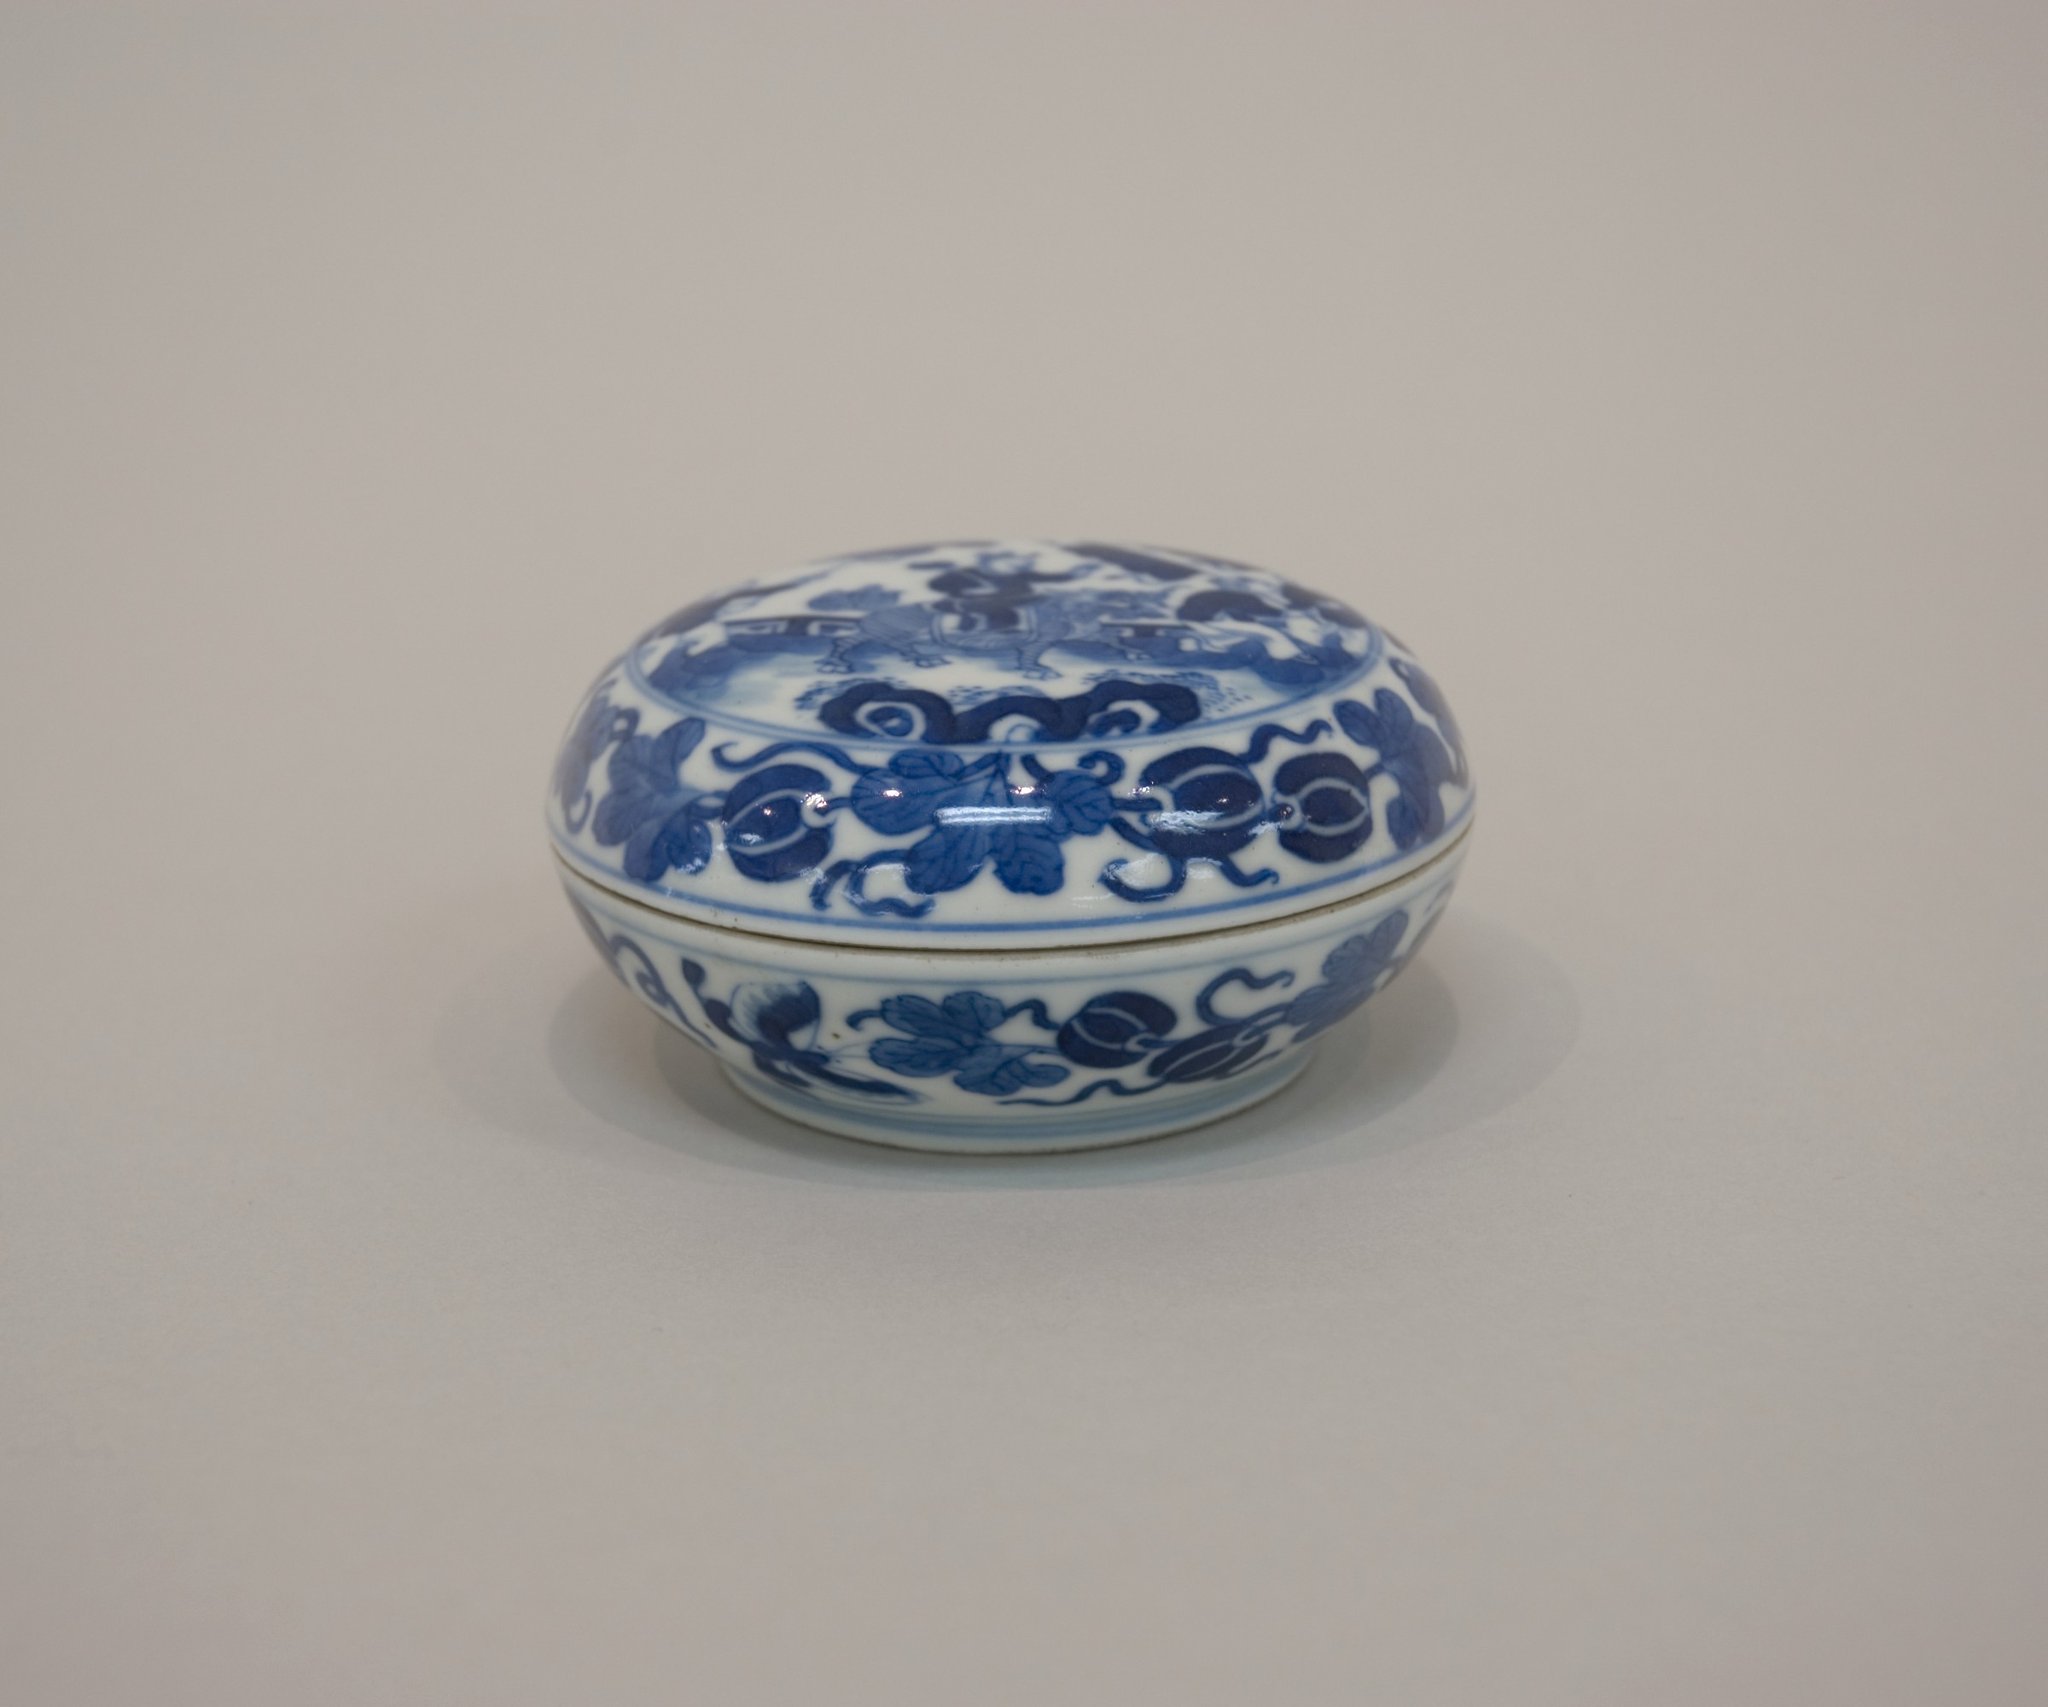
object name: seal paste box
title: Seal paste box with boys and mythical beast qilin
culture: chinese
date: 1667-1733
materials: cobalt, porcelain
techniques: painting, underglaze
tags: men,mythical creatures,flowers,leaves